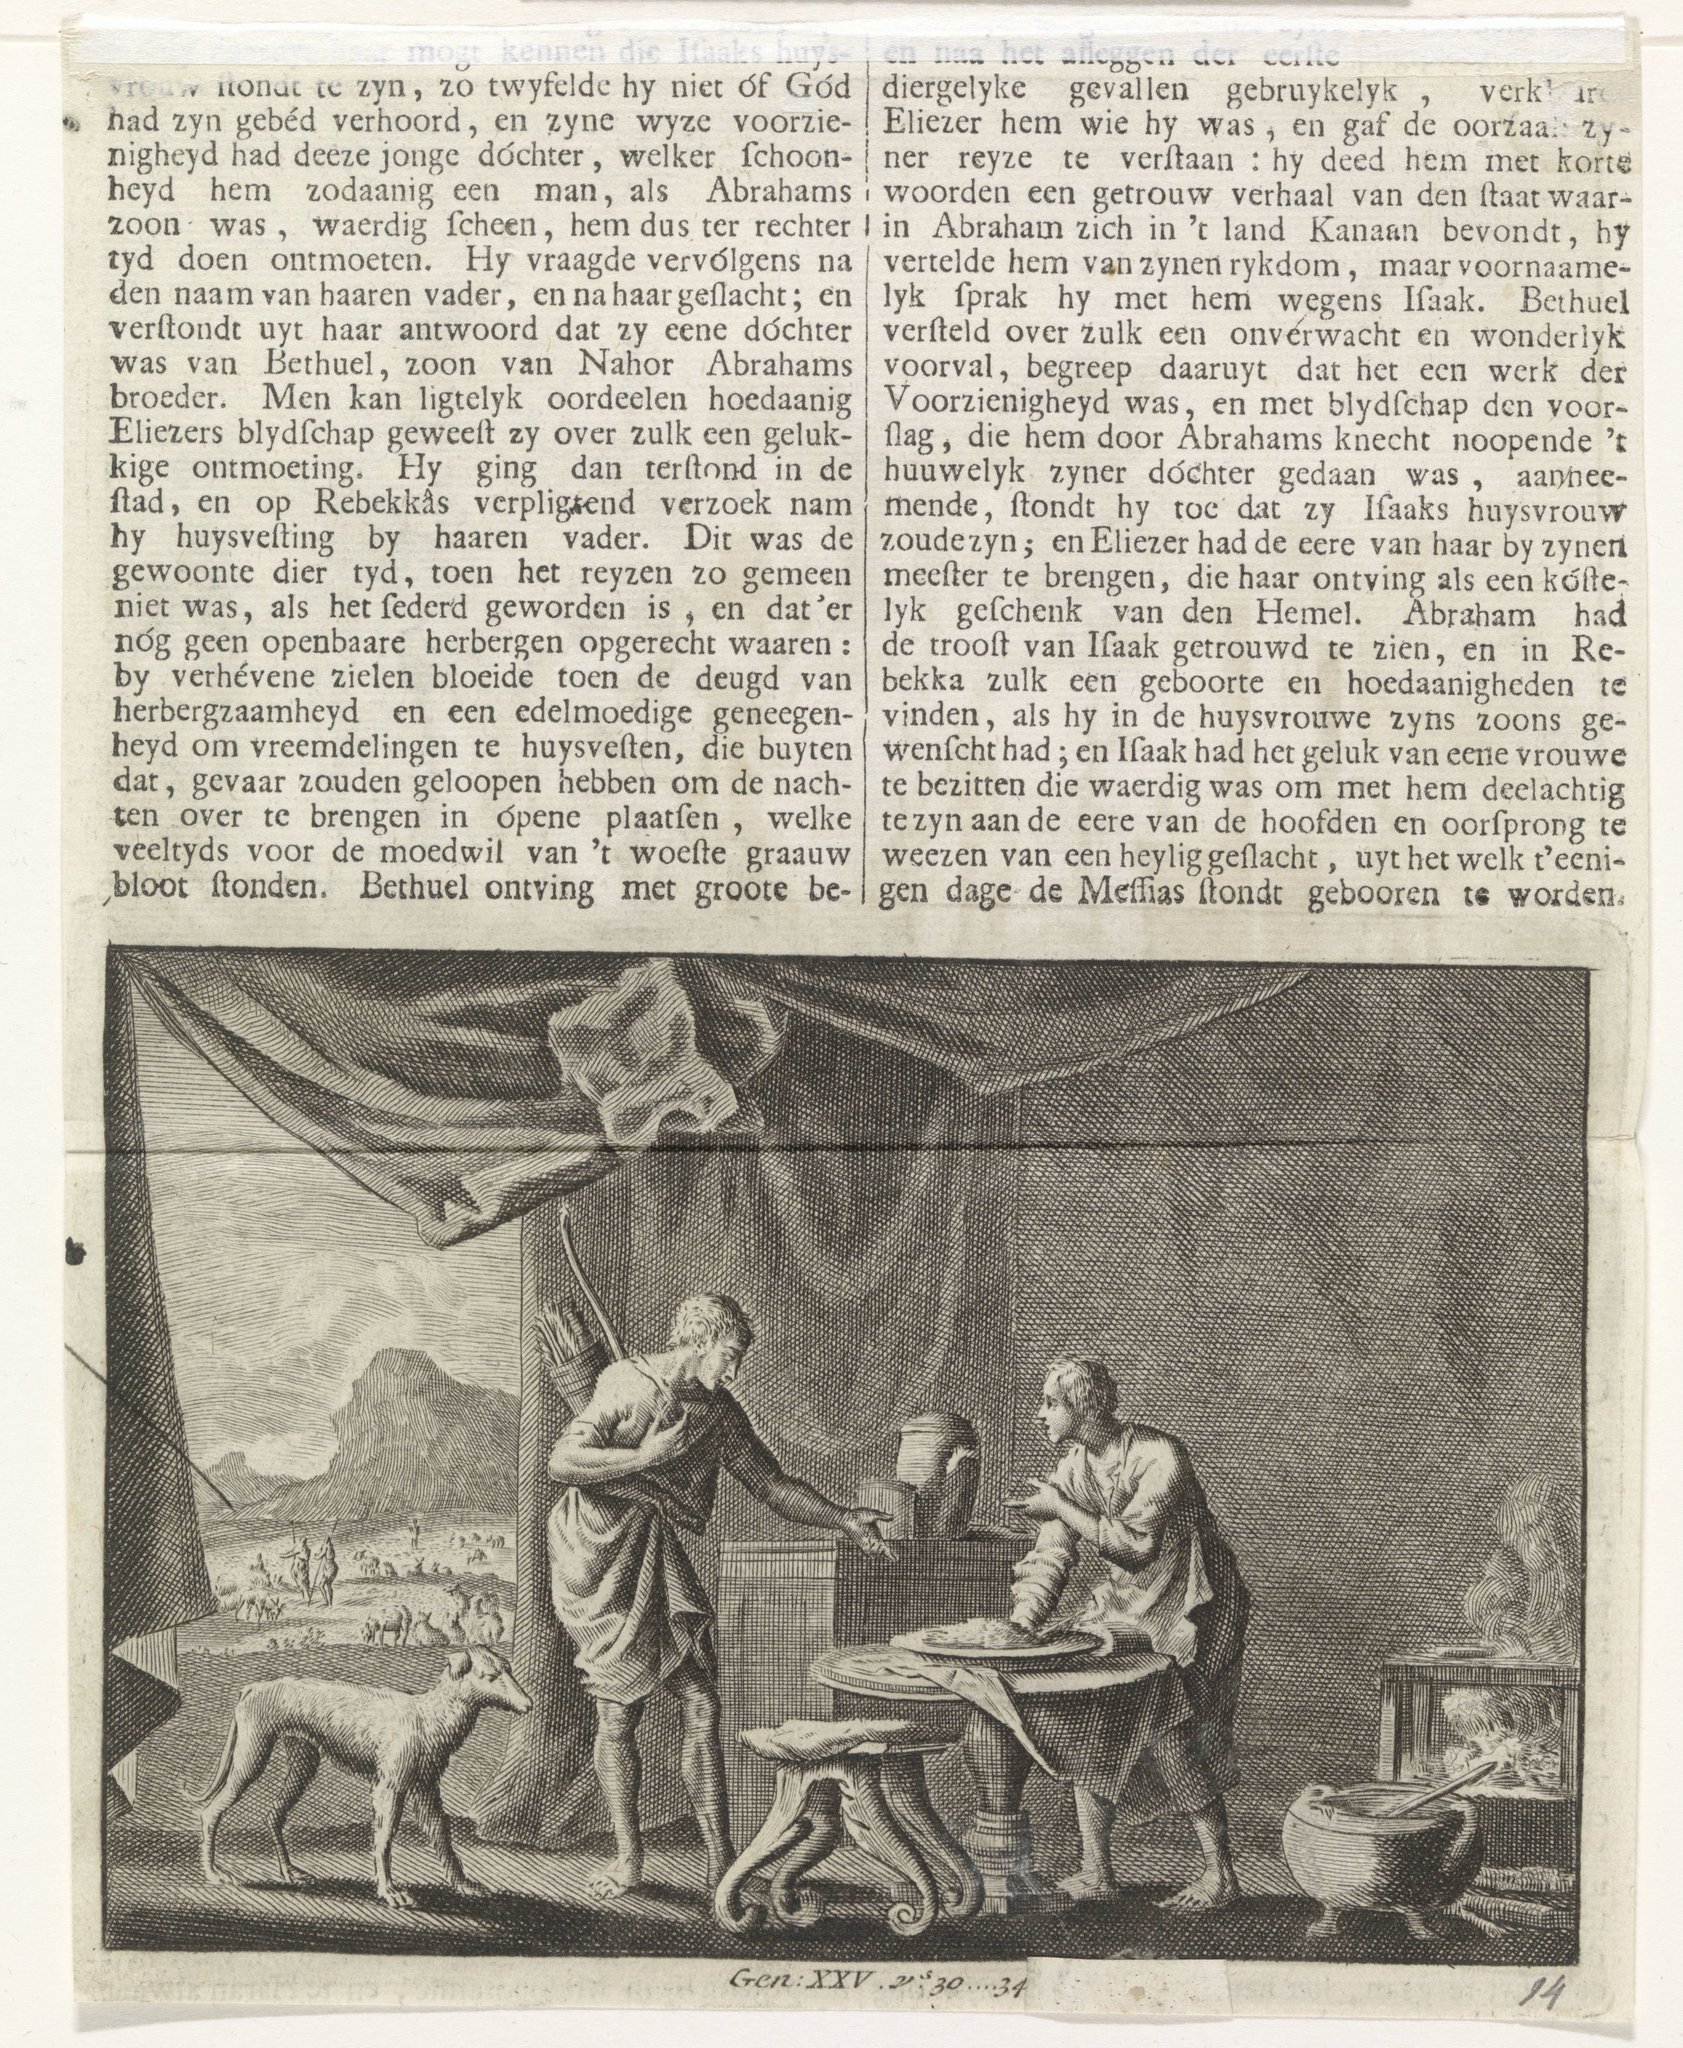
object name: book illustration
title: Esau verkoopt zijn eerstgeboorterecht aan Jakob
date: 1703-1762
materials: paper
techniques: etching, letterpress printing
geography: amsterdam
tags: esau, returning hungry from the hunt, sells his first birthright to jacob for a pottage of lentils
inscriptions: collector's mark: Lugt 2228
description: De prent komt een eerste keer voor als boekillustratie voor David Martin. Historie des Ouden en Nieuwen Testaments. Amsterdam, Pieter Mortier, 1703. Deel I. De boekillustraties voor de Mortierbijbel hebben verschillende staten en kopieën, waarbij de chronologische volgorde moeilijk te achterhalen valt. Als boekillustraties werden ze bovendien herhaaldelijk opnieuw gebruikt voor andere boekwerken.